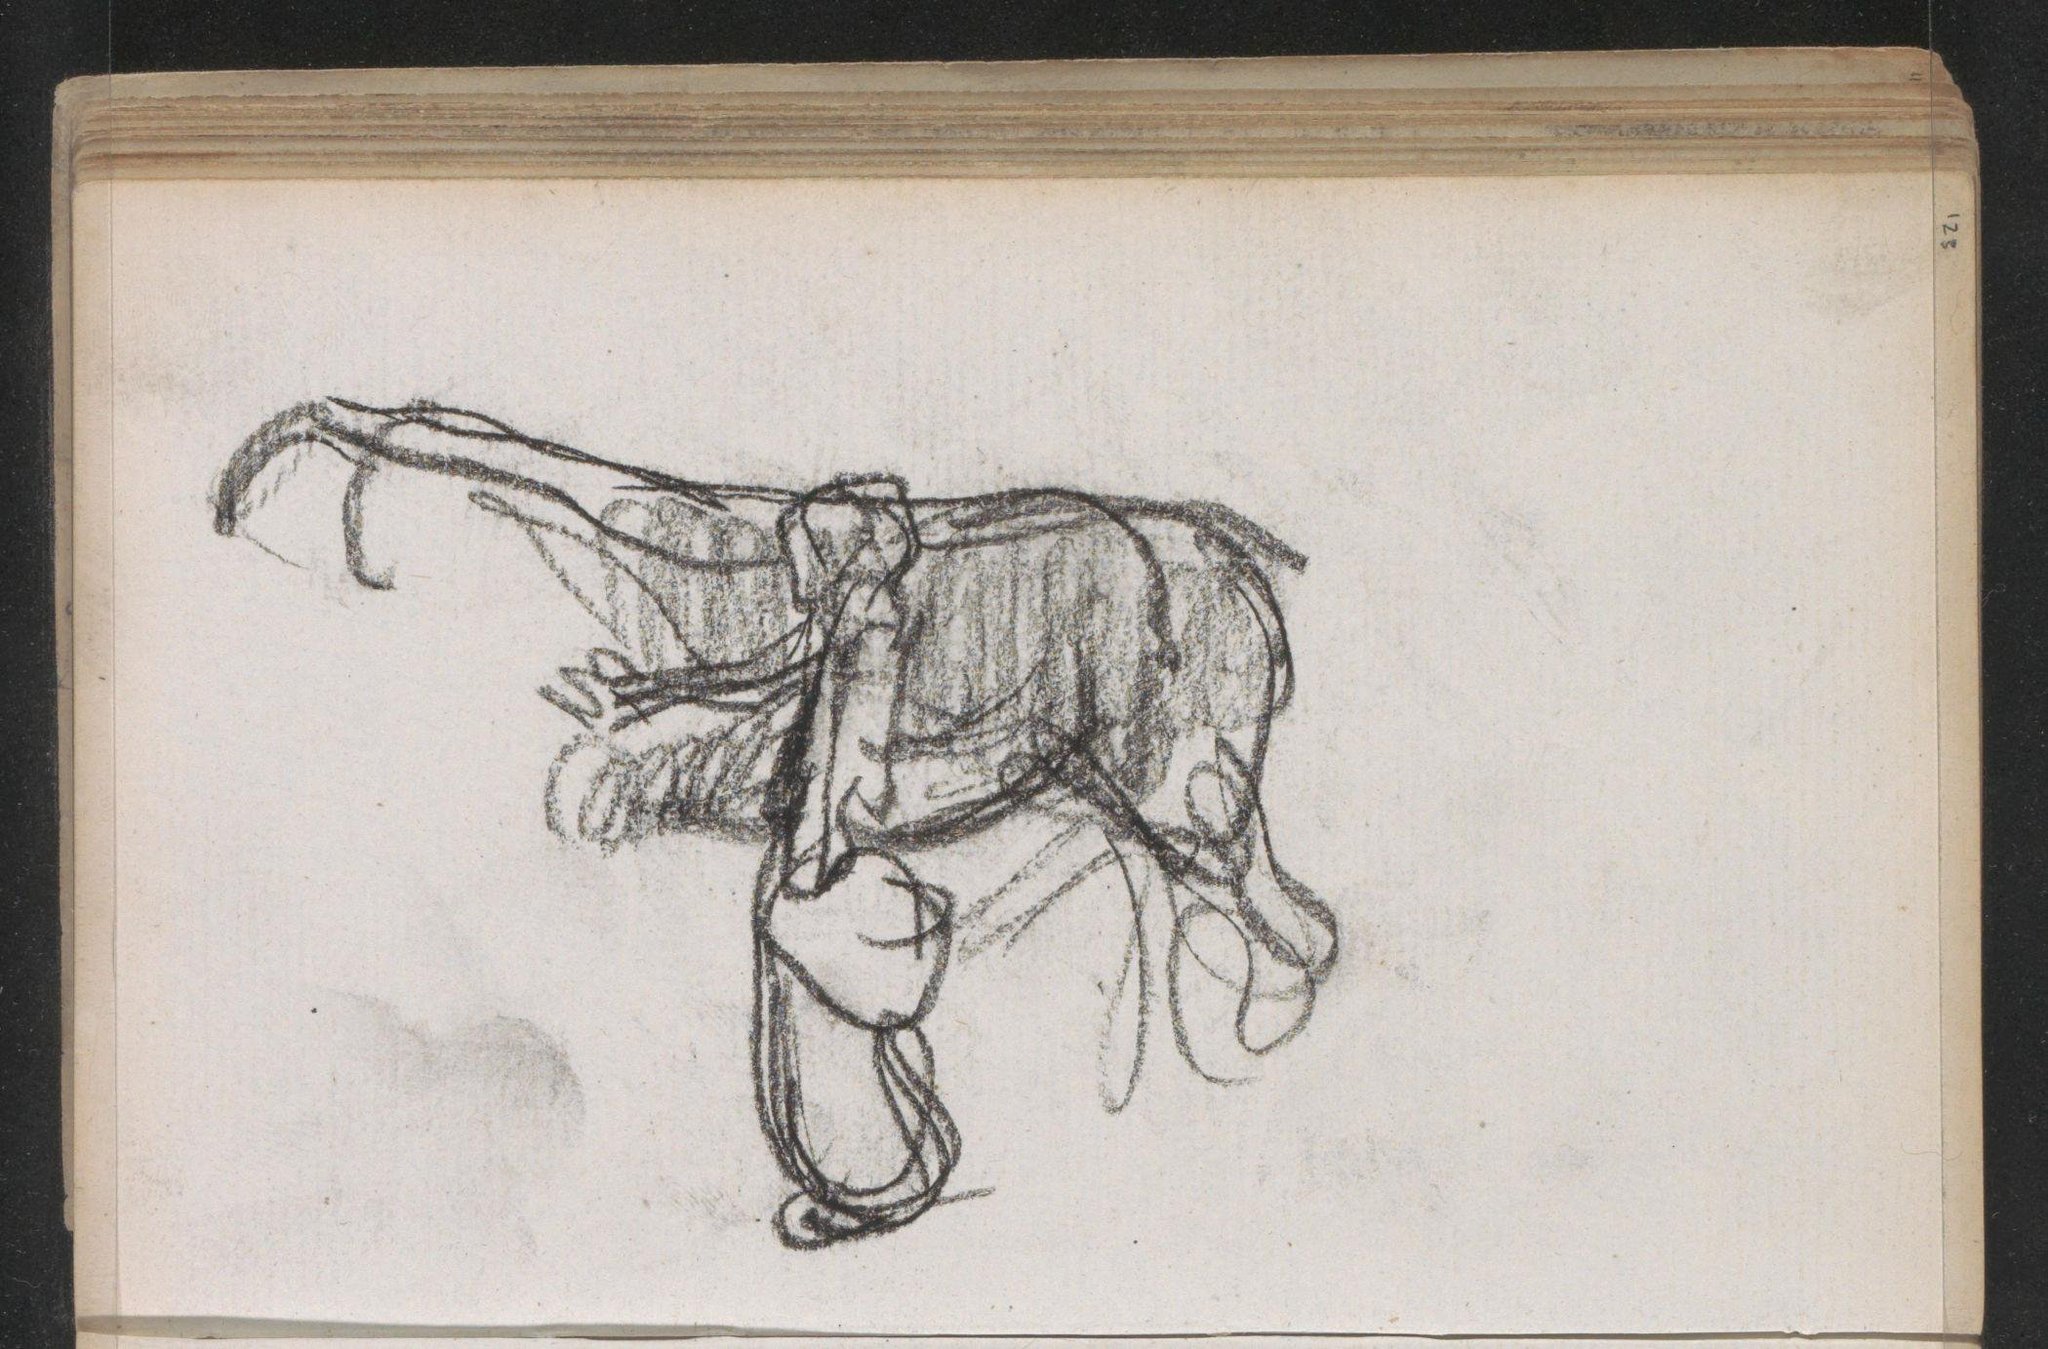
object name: sketchbook leaf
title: Boerin naast één of twee paarden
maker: george hendrik breitner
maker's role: draughtsman, painter, print maker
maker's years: 1857-1923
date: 1884-1886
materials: chalk, paper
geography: drenthe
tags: farmers - aa - female farmer, farmer's wife, horse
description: Pagina 123 uit een schetsboek met 67 bladen vervaardigd in Drenthe.